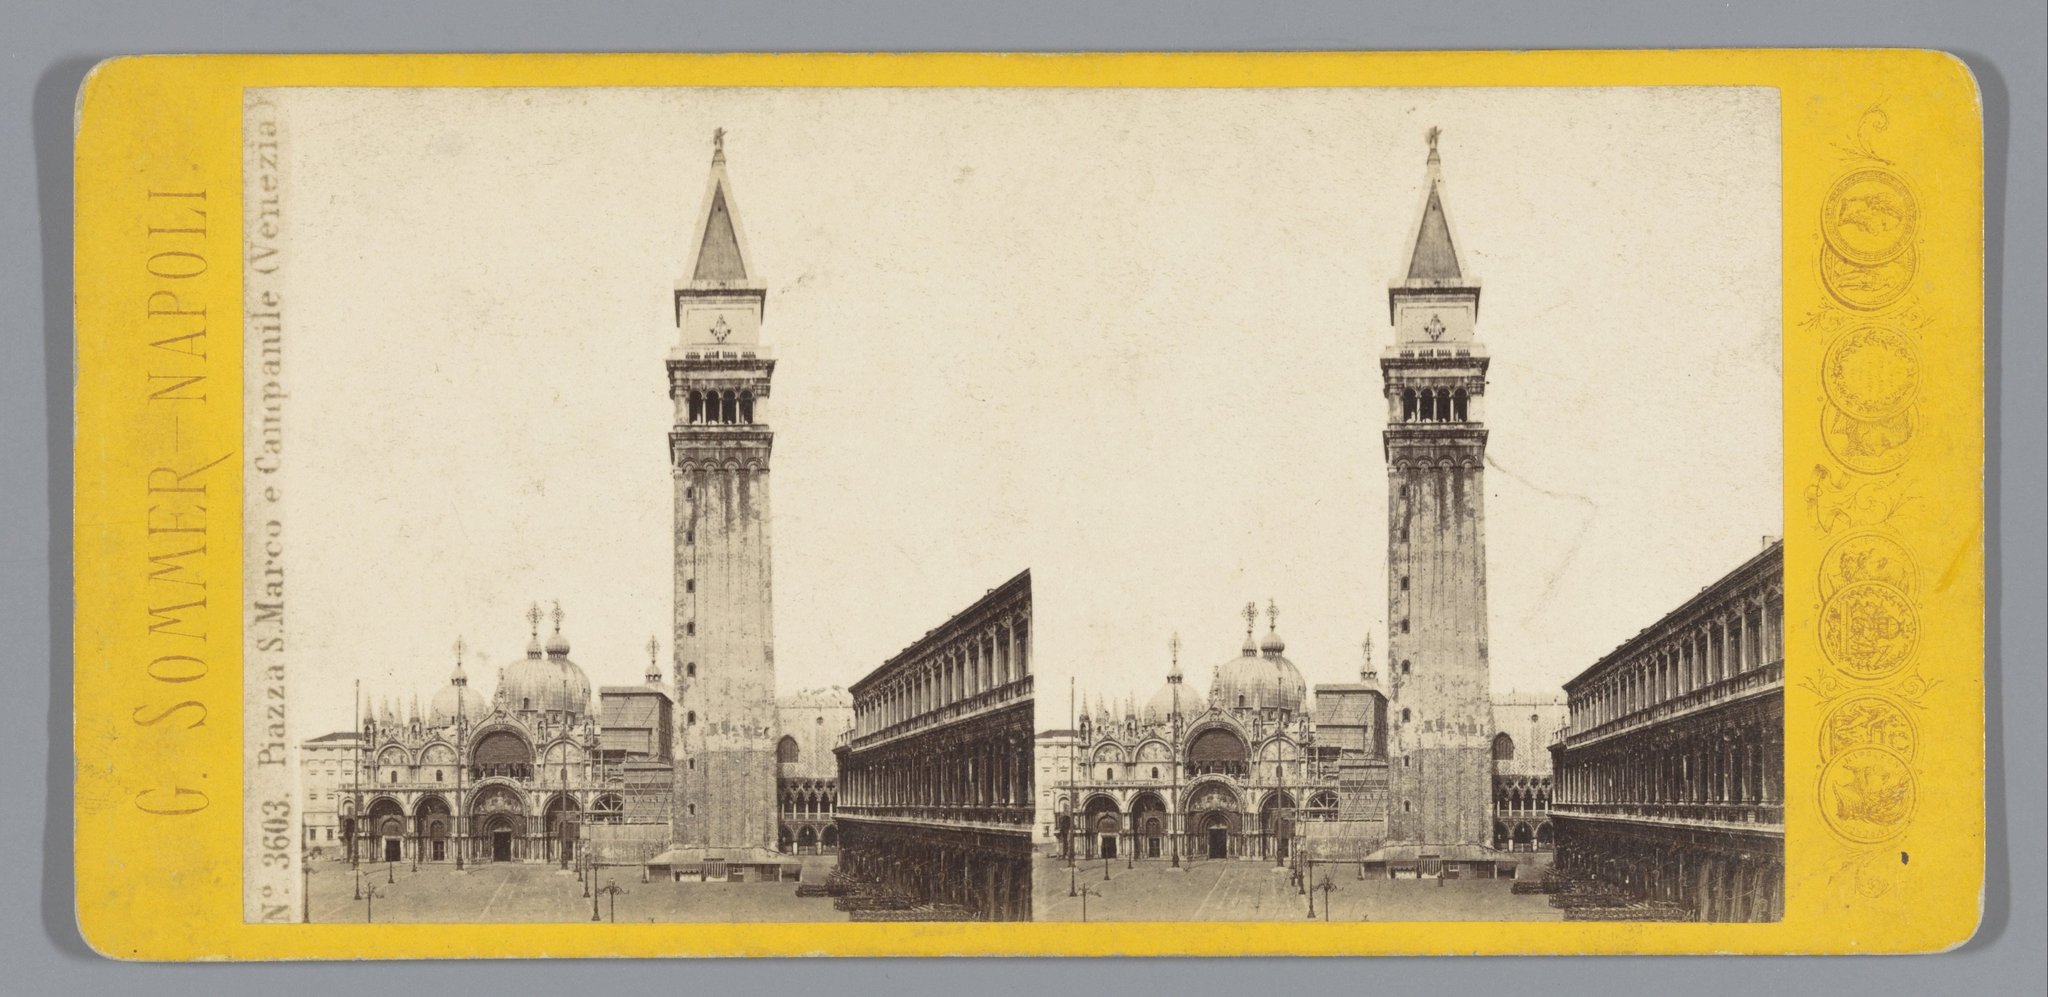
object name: stereograph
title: Piazza S. Marco e Campanile (Venezia)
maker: giorgio sommer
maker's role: fotograaf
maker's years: 1834-1914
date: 1860-1880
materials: cardboard, photographic support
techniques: albumen print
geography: venice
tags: parts of church exterior and annexes: campanile, square, place, circus, etc.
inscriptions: number: ‘No. 3603.’, inscription: ‘Venetie : Ponte Rialto’